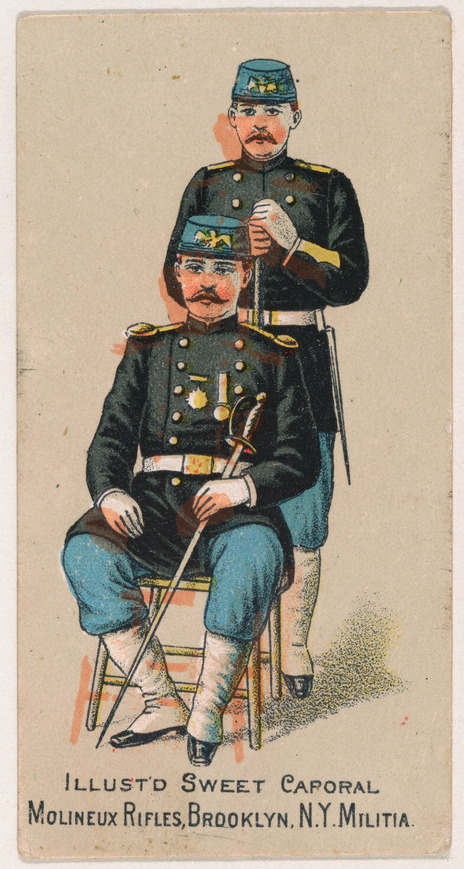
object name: print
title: Molineux Rifles, Brooklyn, New York Militia, from the Military Series (N224) issued by Kinney Tobacco Company to promote Sweet Caporal Cigarettes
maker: kinney brothers tobacco company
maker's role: publisher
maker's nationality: american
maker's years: 1869-2011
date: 1888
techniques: color lithograph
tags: military,swords,men